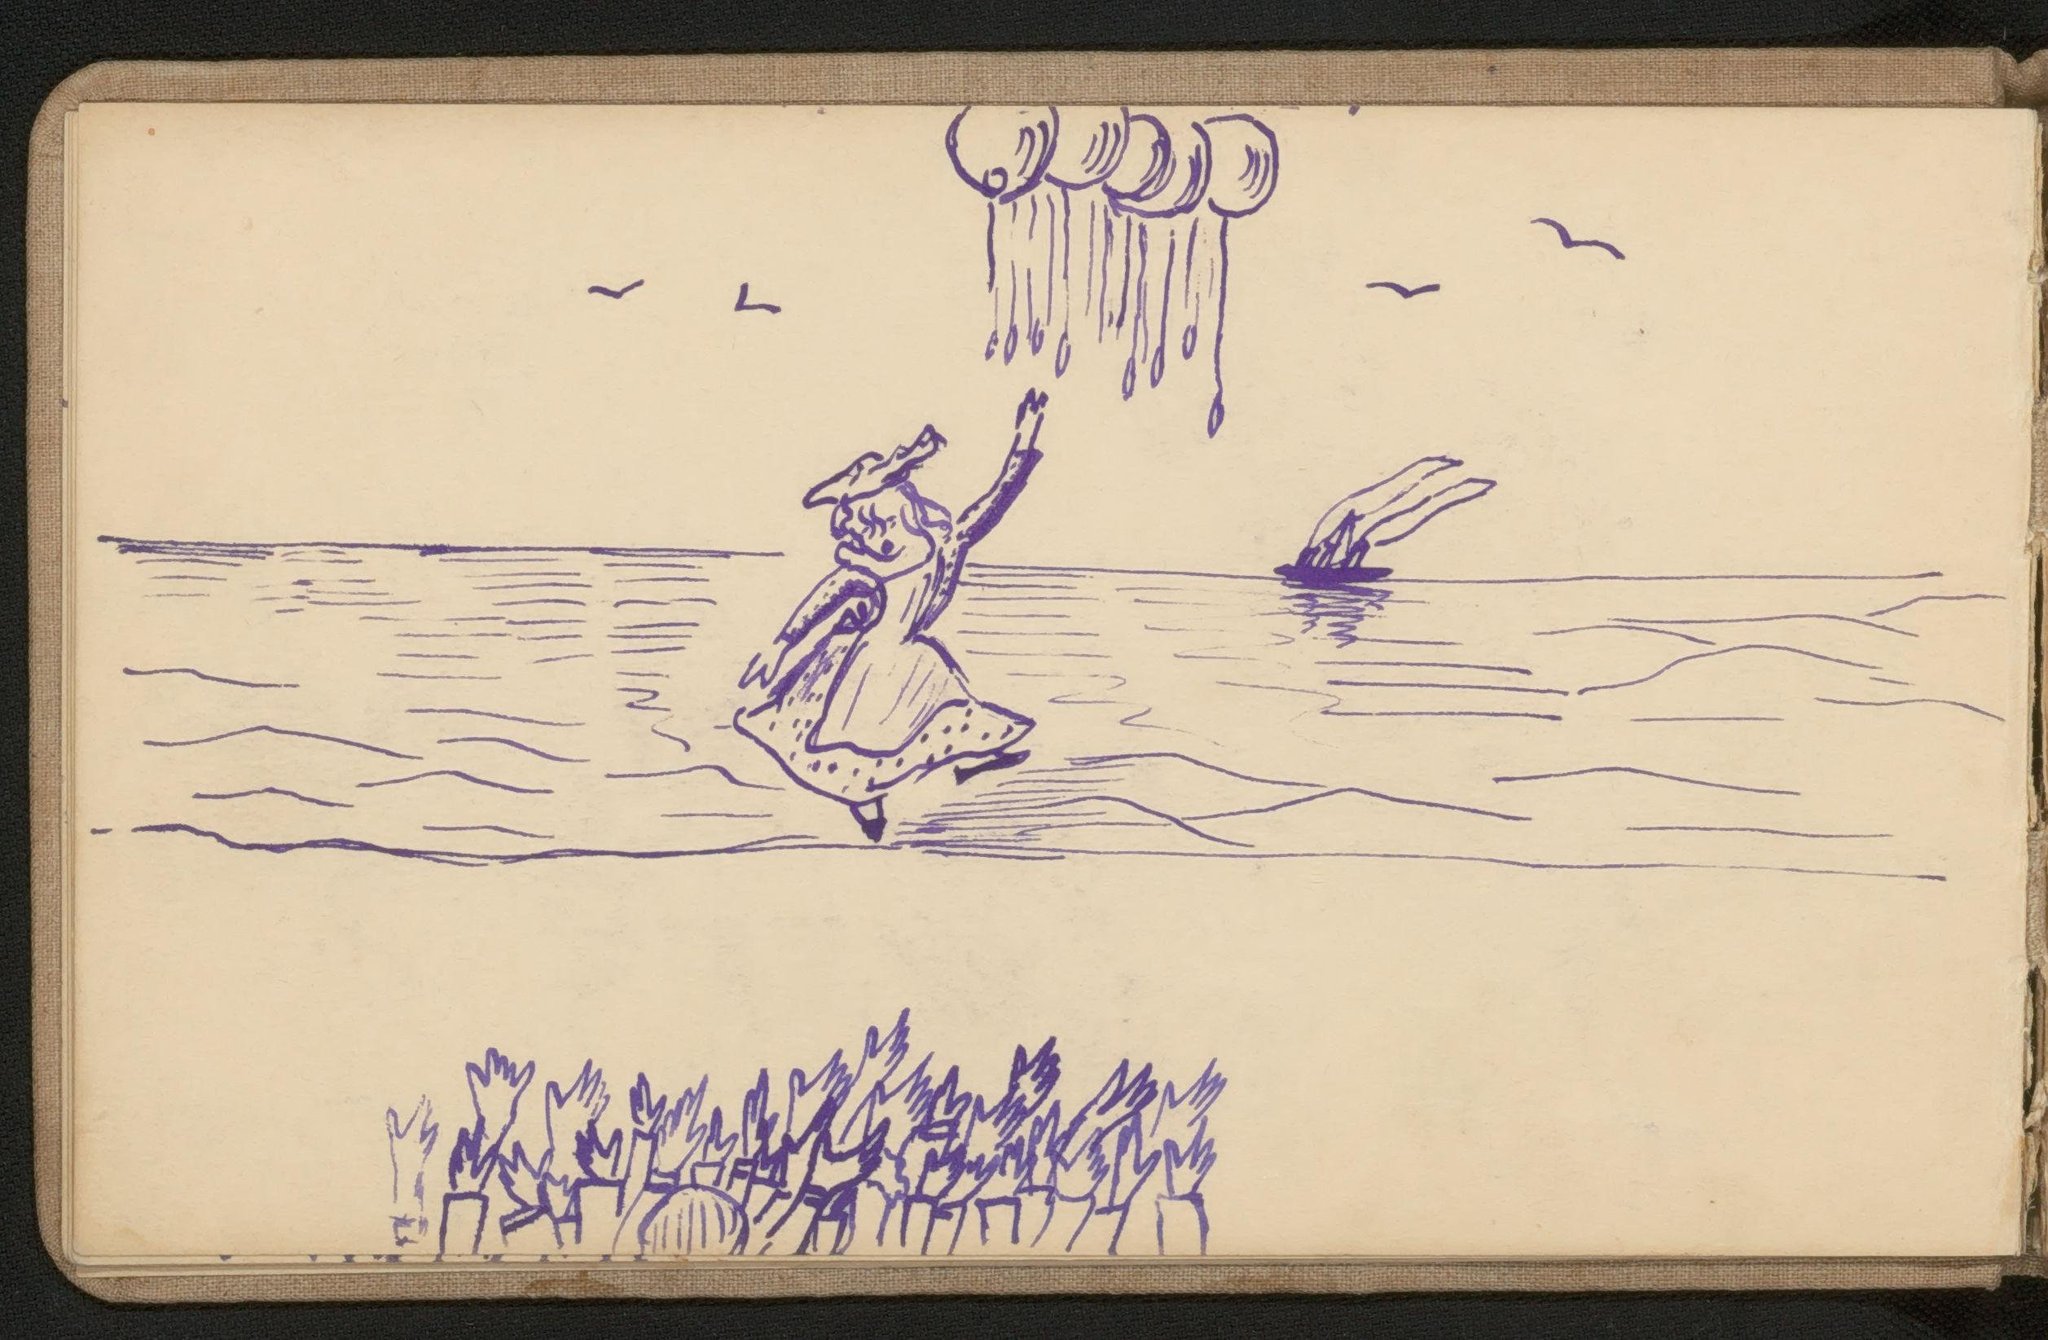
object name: sketchbook leaf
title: Moeder laat de ballonnen los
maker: Anonymous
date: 1875-1920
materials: ink, paper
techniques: pen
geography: netherlands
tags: beach (as place of recreation), the family travelling, on holiday, (flying a) gas balloon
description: Moeder laat de ballonnen los en zakt weer naar beneden naar het strand. Onderdeel van het schetsboek met humoristische tekeningen over het leven van een 'famille nombreuse'. Onderwerpsrubrieken binnen de Atlas Zeden en Gewoonten: Zeden en Gewoonten in Engeren Zin, Des menschen beging, midden en einde, Kinderleven.